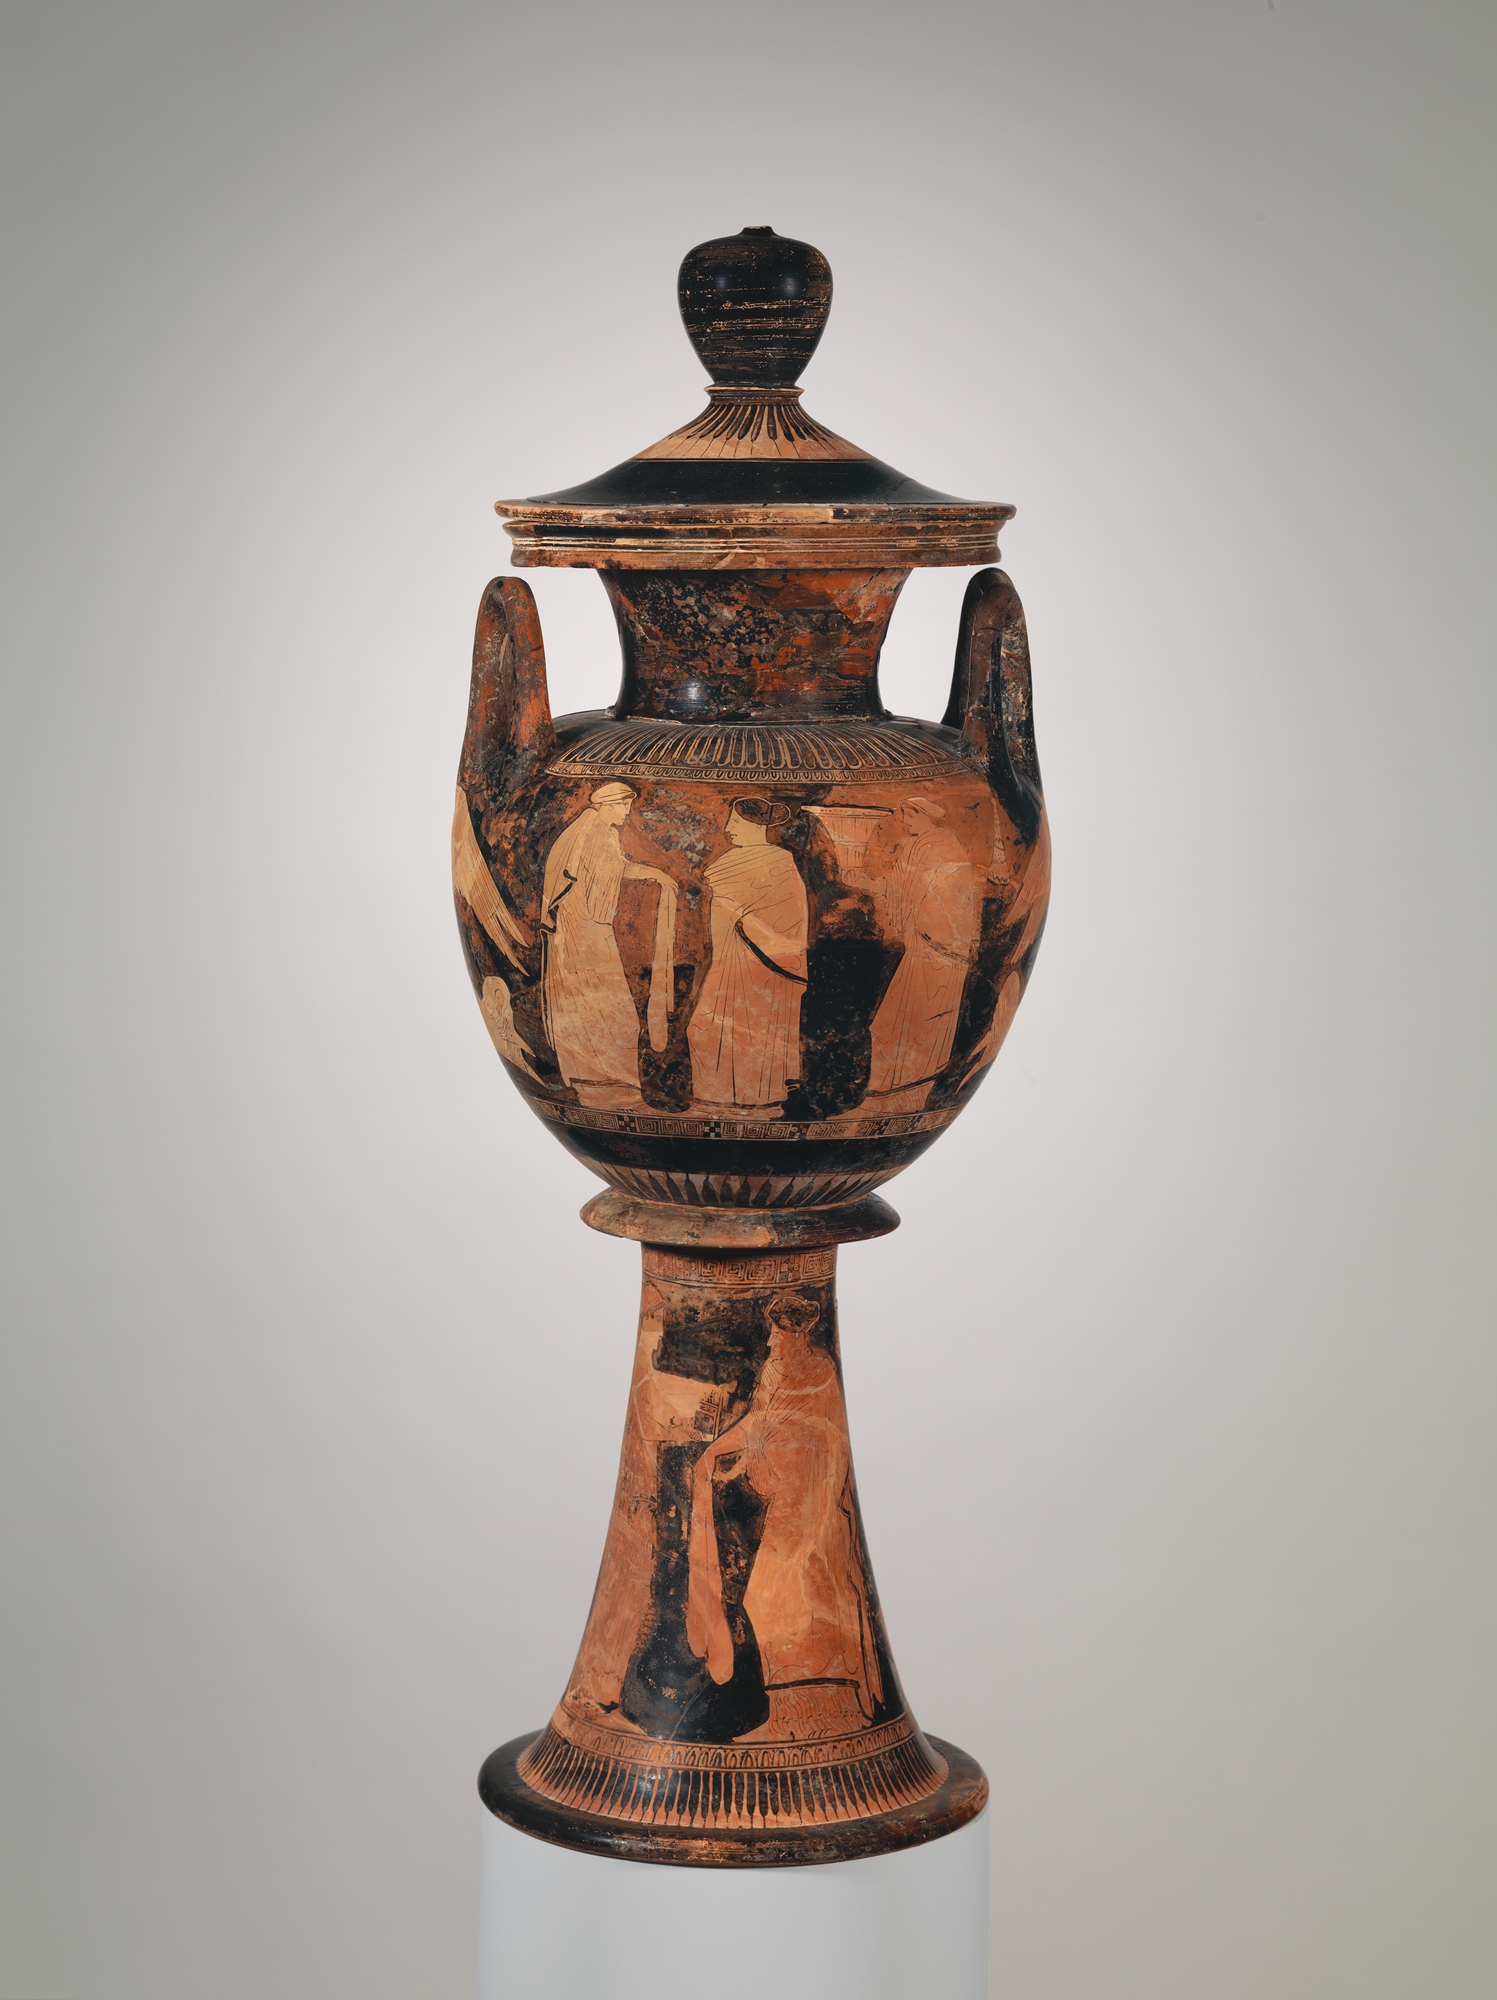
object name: lebes gamikos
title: Terracotta lebes gamikos (round-bottomed bowl with handles and stand used in weddings)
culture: greek, attic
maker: washing painter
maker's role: artist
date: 430-420 BCE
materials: terracotta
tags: men,women